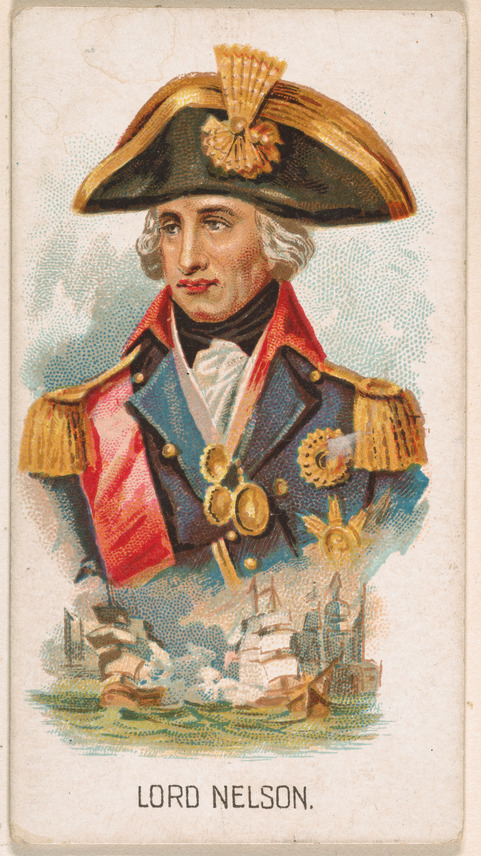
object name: print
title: Lord Nelson, from Leaders series (N222) issued by Kinney Bros.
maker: kinney brothers tobacco company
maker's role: publisher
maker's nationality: american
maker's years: 1869-2011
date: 1888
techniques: color lithograph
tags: men,admirals